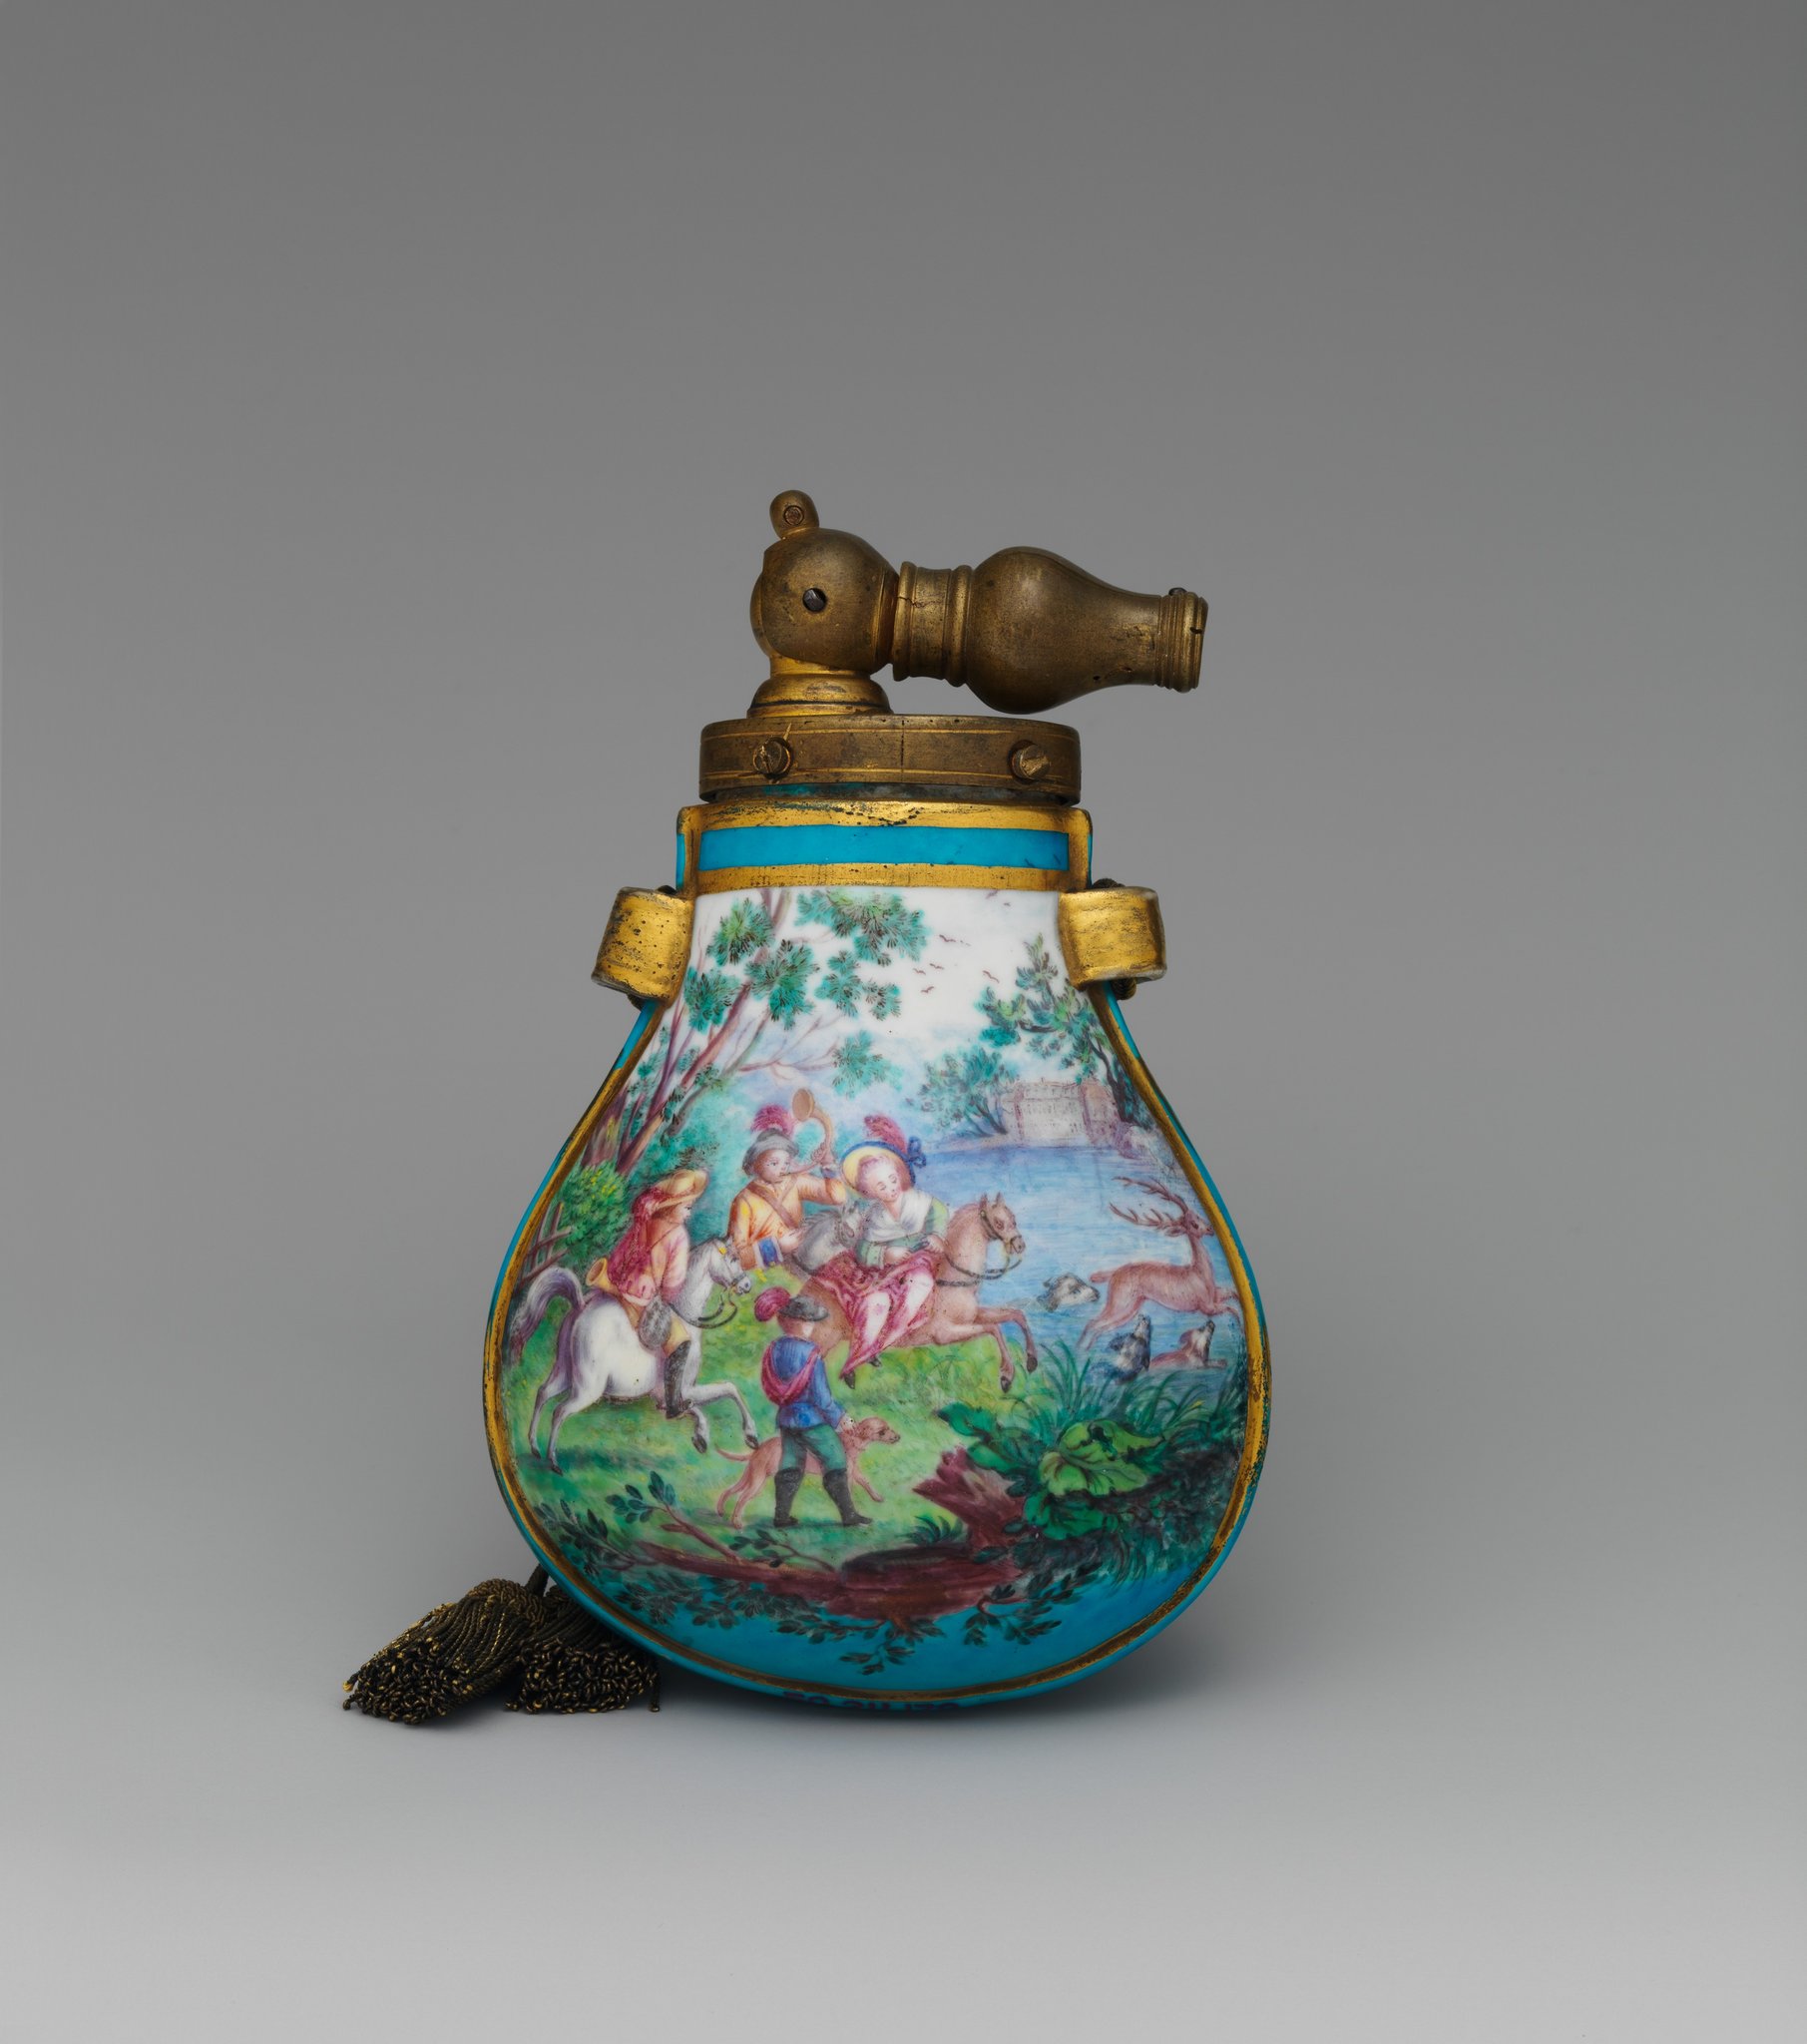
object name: powder horn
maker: vincennes manufactory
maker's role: manufactory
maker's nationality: french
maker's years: 1740-1756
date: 1701-1900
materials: soft paste porcelain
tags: military equipment,deer,horses